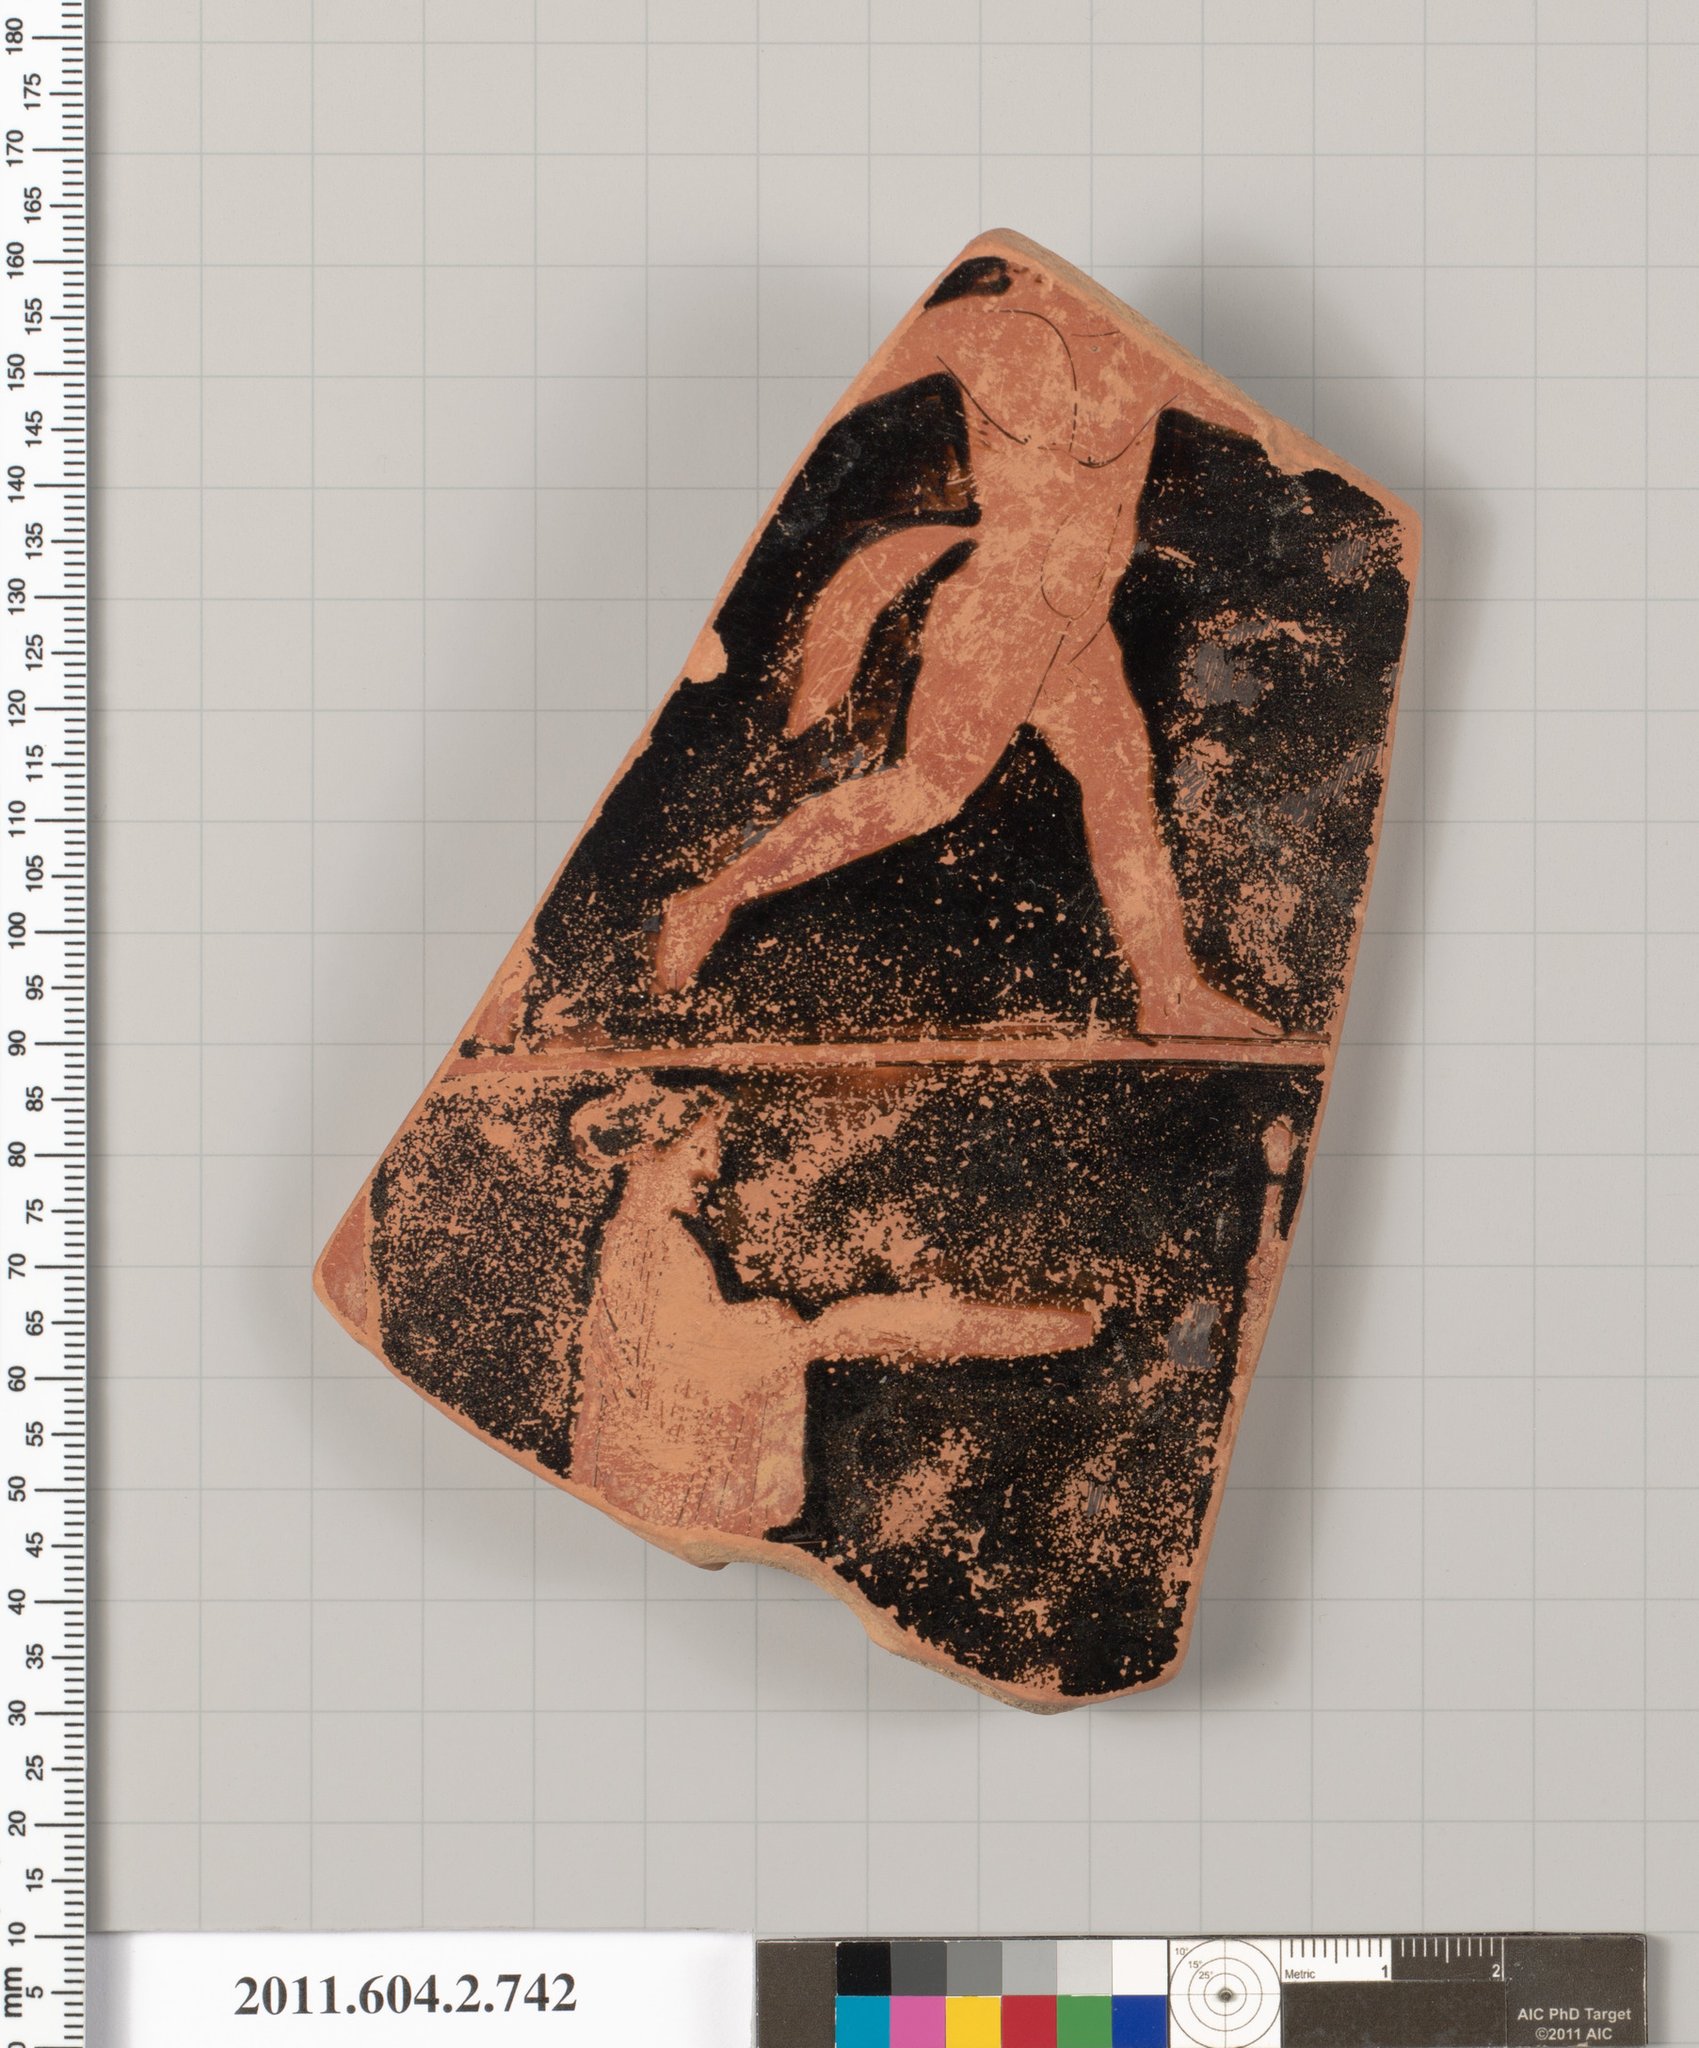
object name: calyx krater fragment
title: Terracotta fragment of a calyx-krater (bowl for mixing wine and water)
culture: greek, attic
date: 460-450 BCE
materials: terracotta